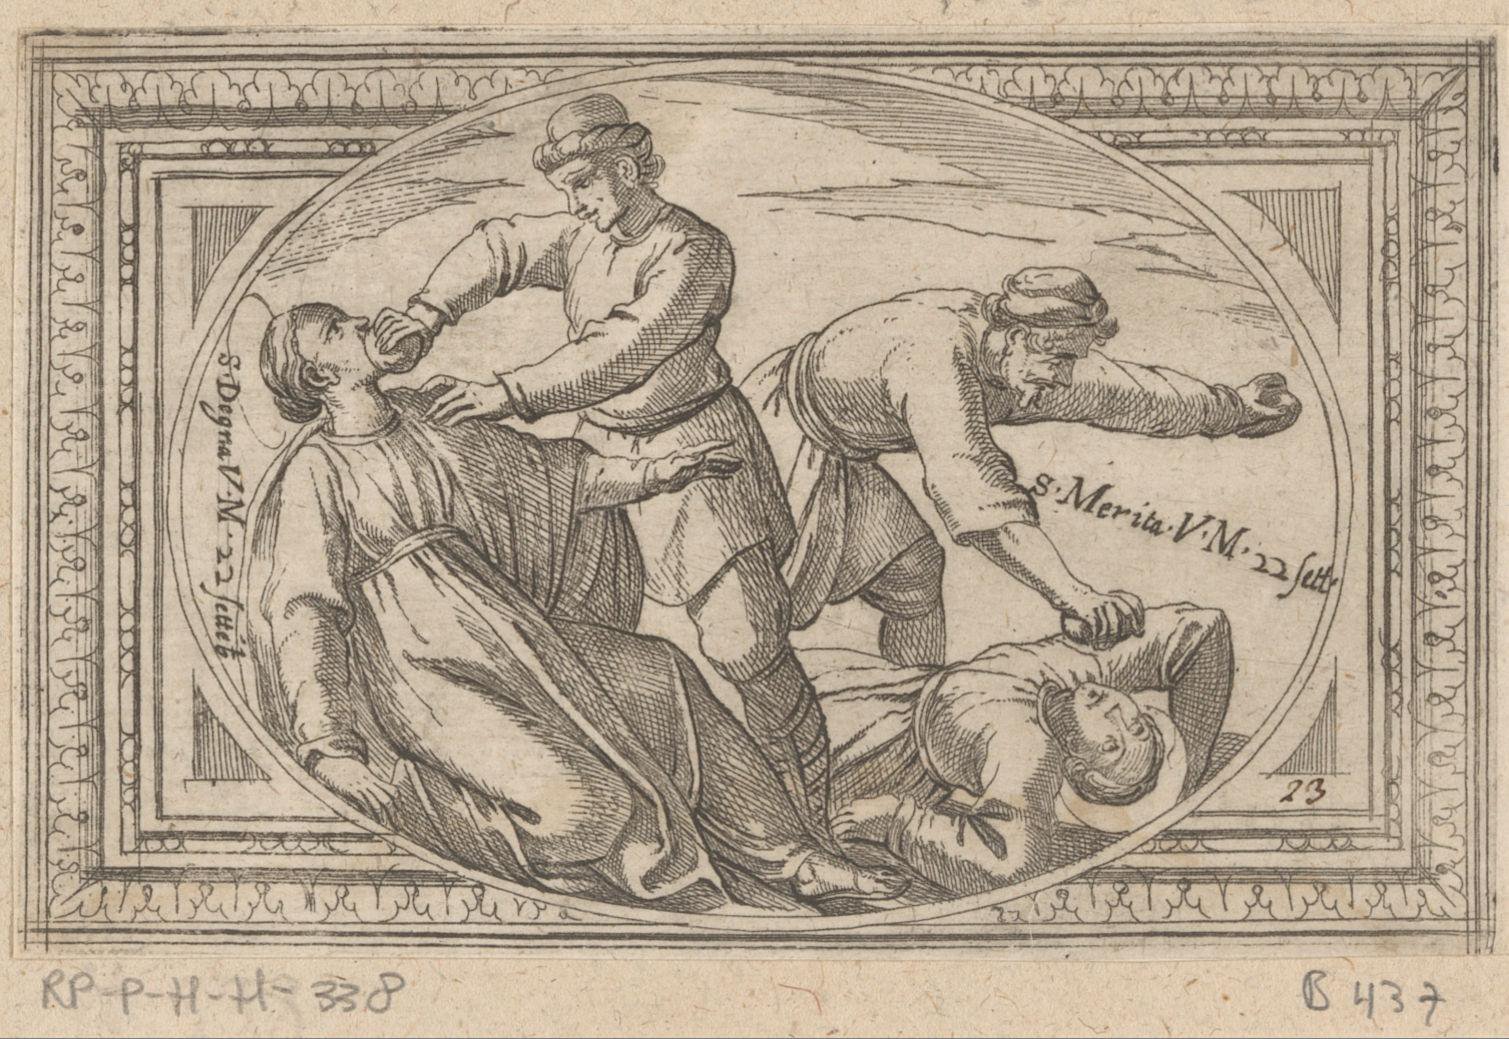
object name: print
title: Imagini di moltes vergini Rom nel martirio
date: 1565-1630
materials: paper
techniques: etching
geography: rome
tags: martyr(s) (often with palm-branches) - qq - female martyr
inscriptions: number: ‘23’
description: Deze prent maakt deel uit van een reeks van 73 prenten (+ titelprent) met voorstellingen van Romeinse martelaressen.